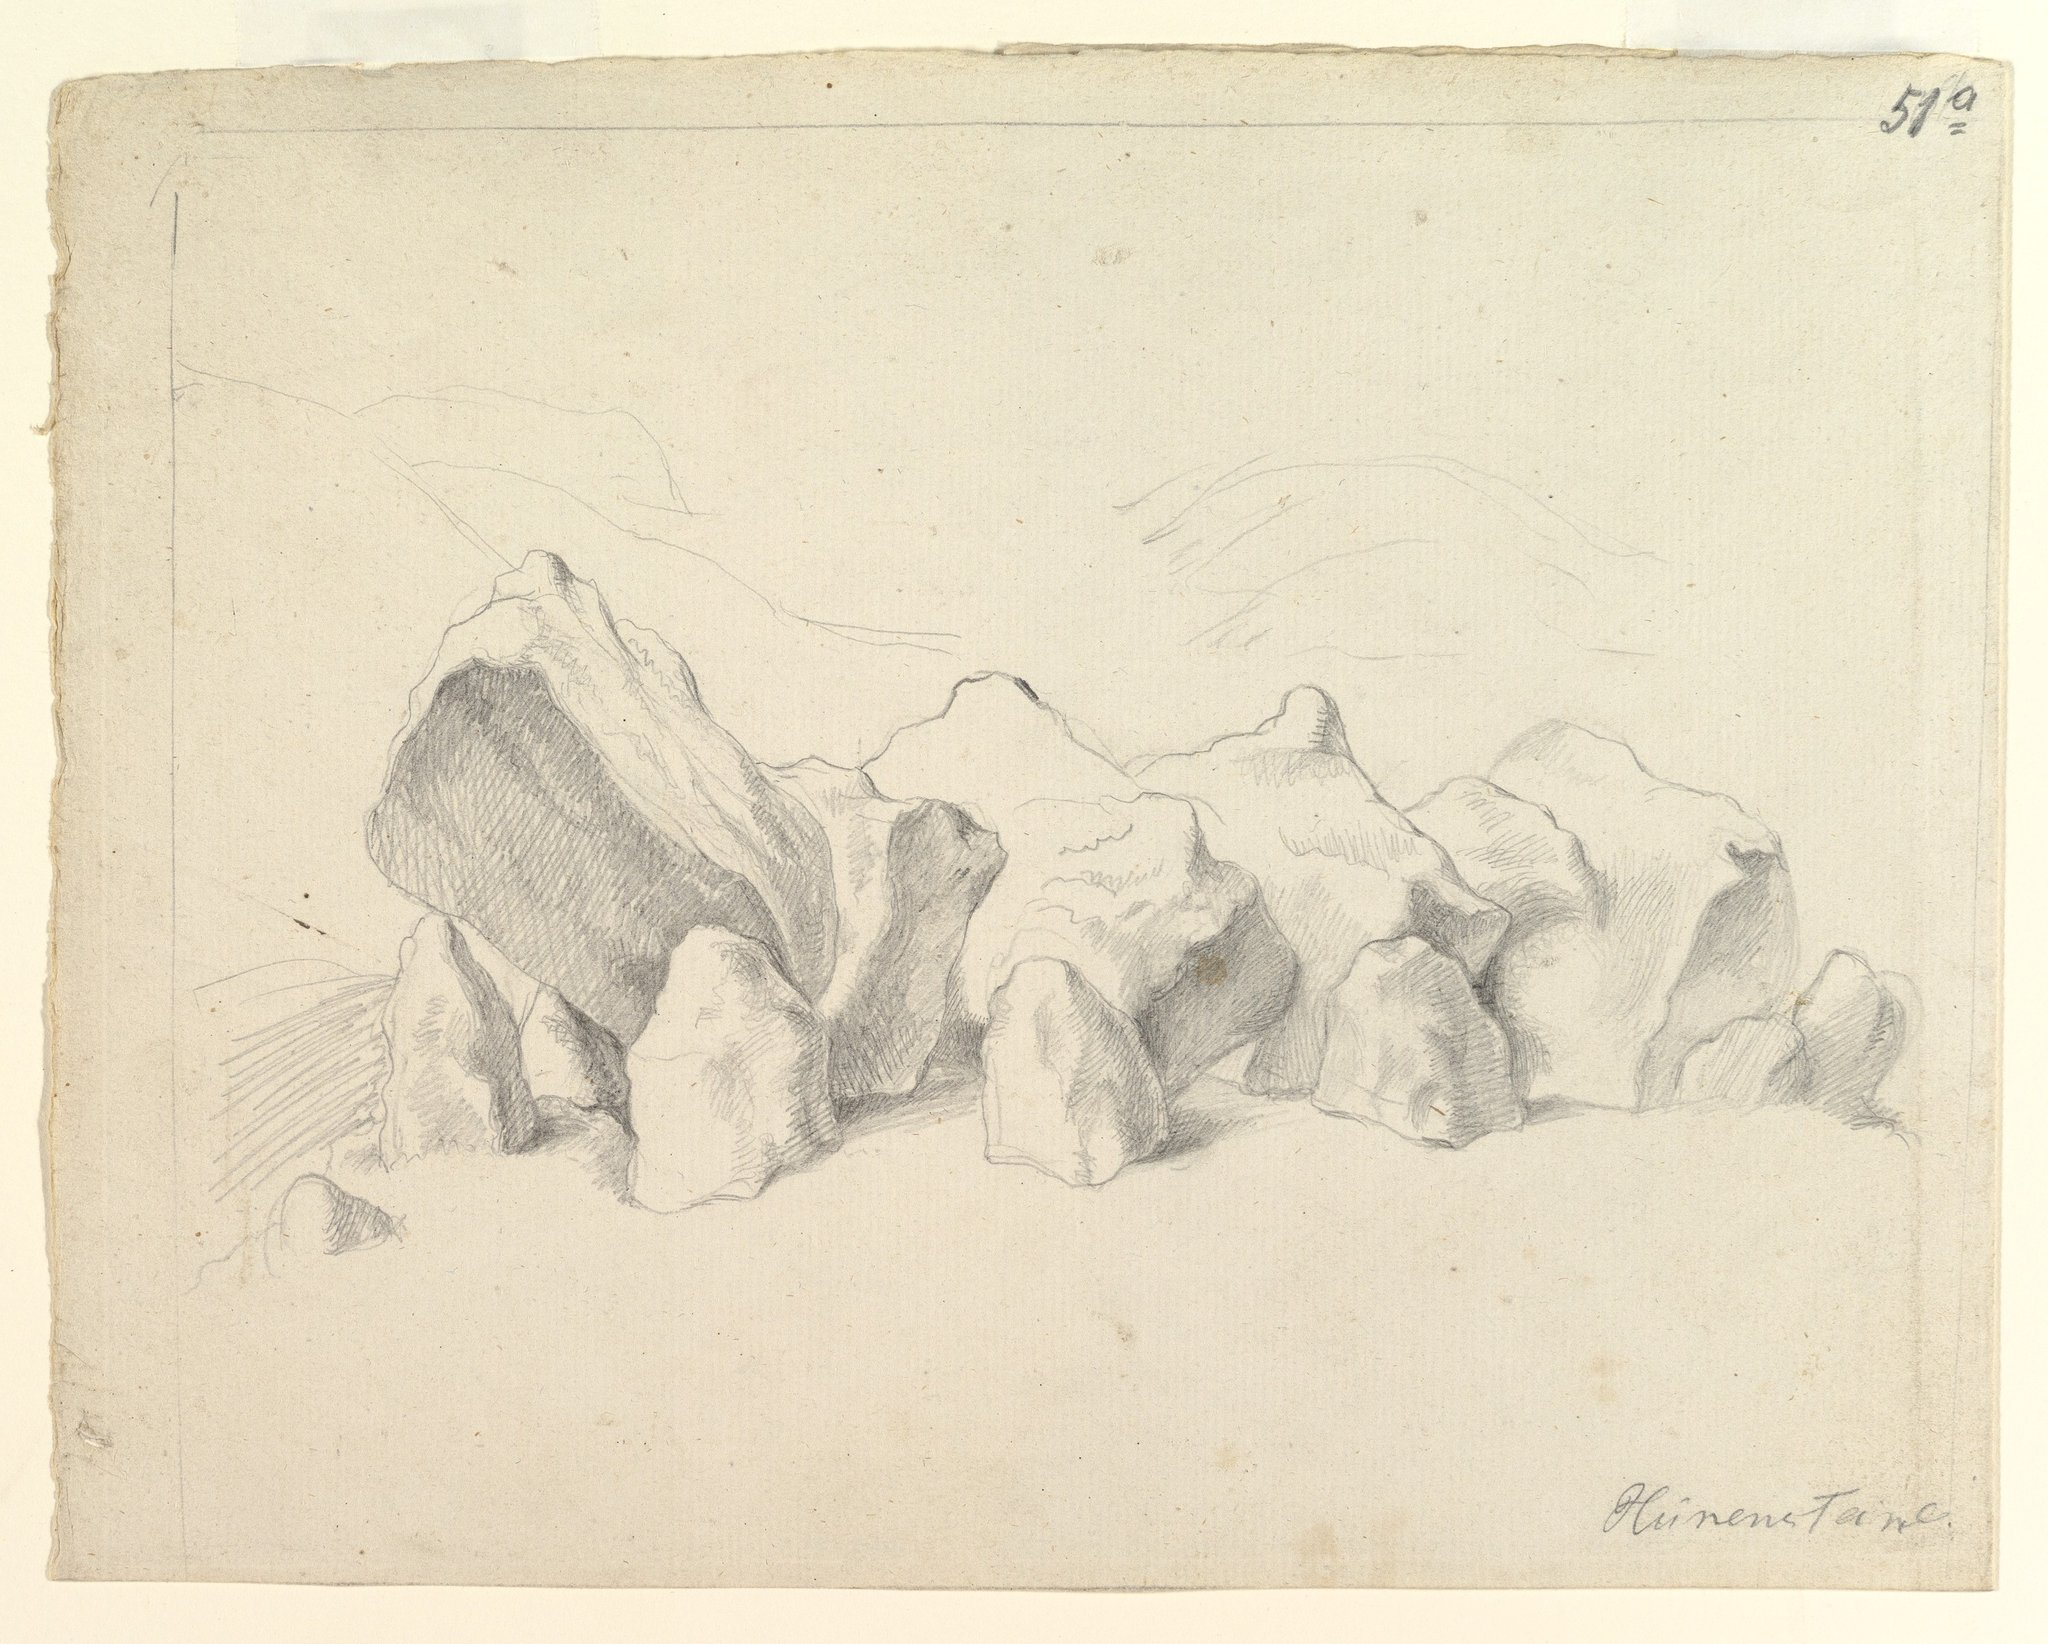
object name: drawing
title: A Prehistoric Stone Circle on a Mound, an Extensive Landscape Beyond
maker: johann heinrich wilhelm tischbein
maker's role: artist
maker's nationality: german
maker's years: 1751-1829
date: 1734-1833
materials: chalk, graphite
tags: landscapes